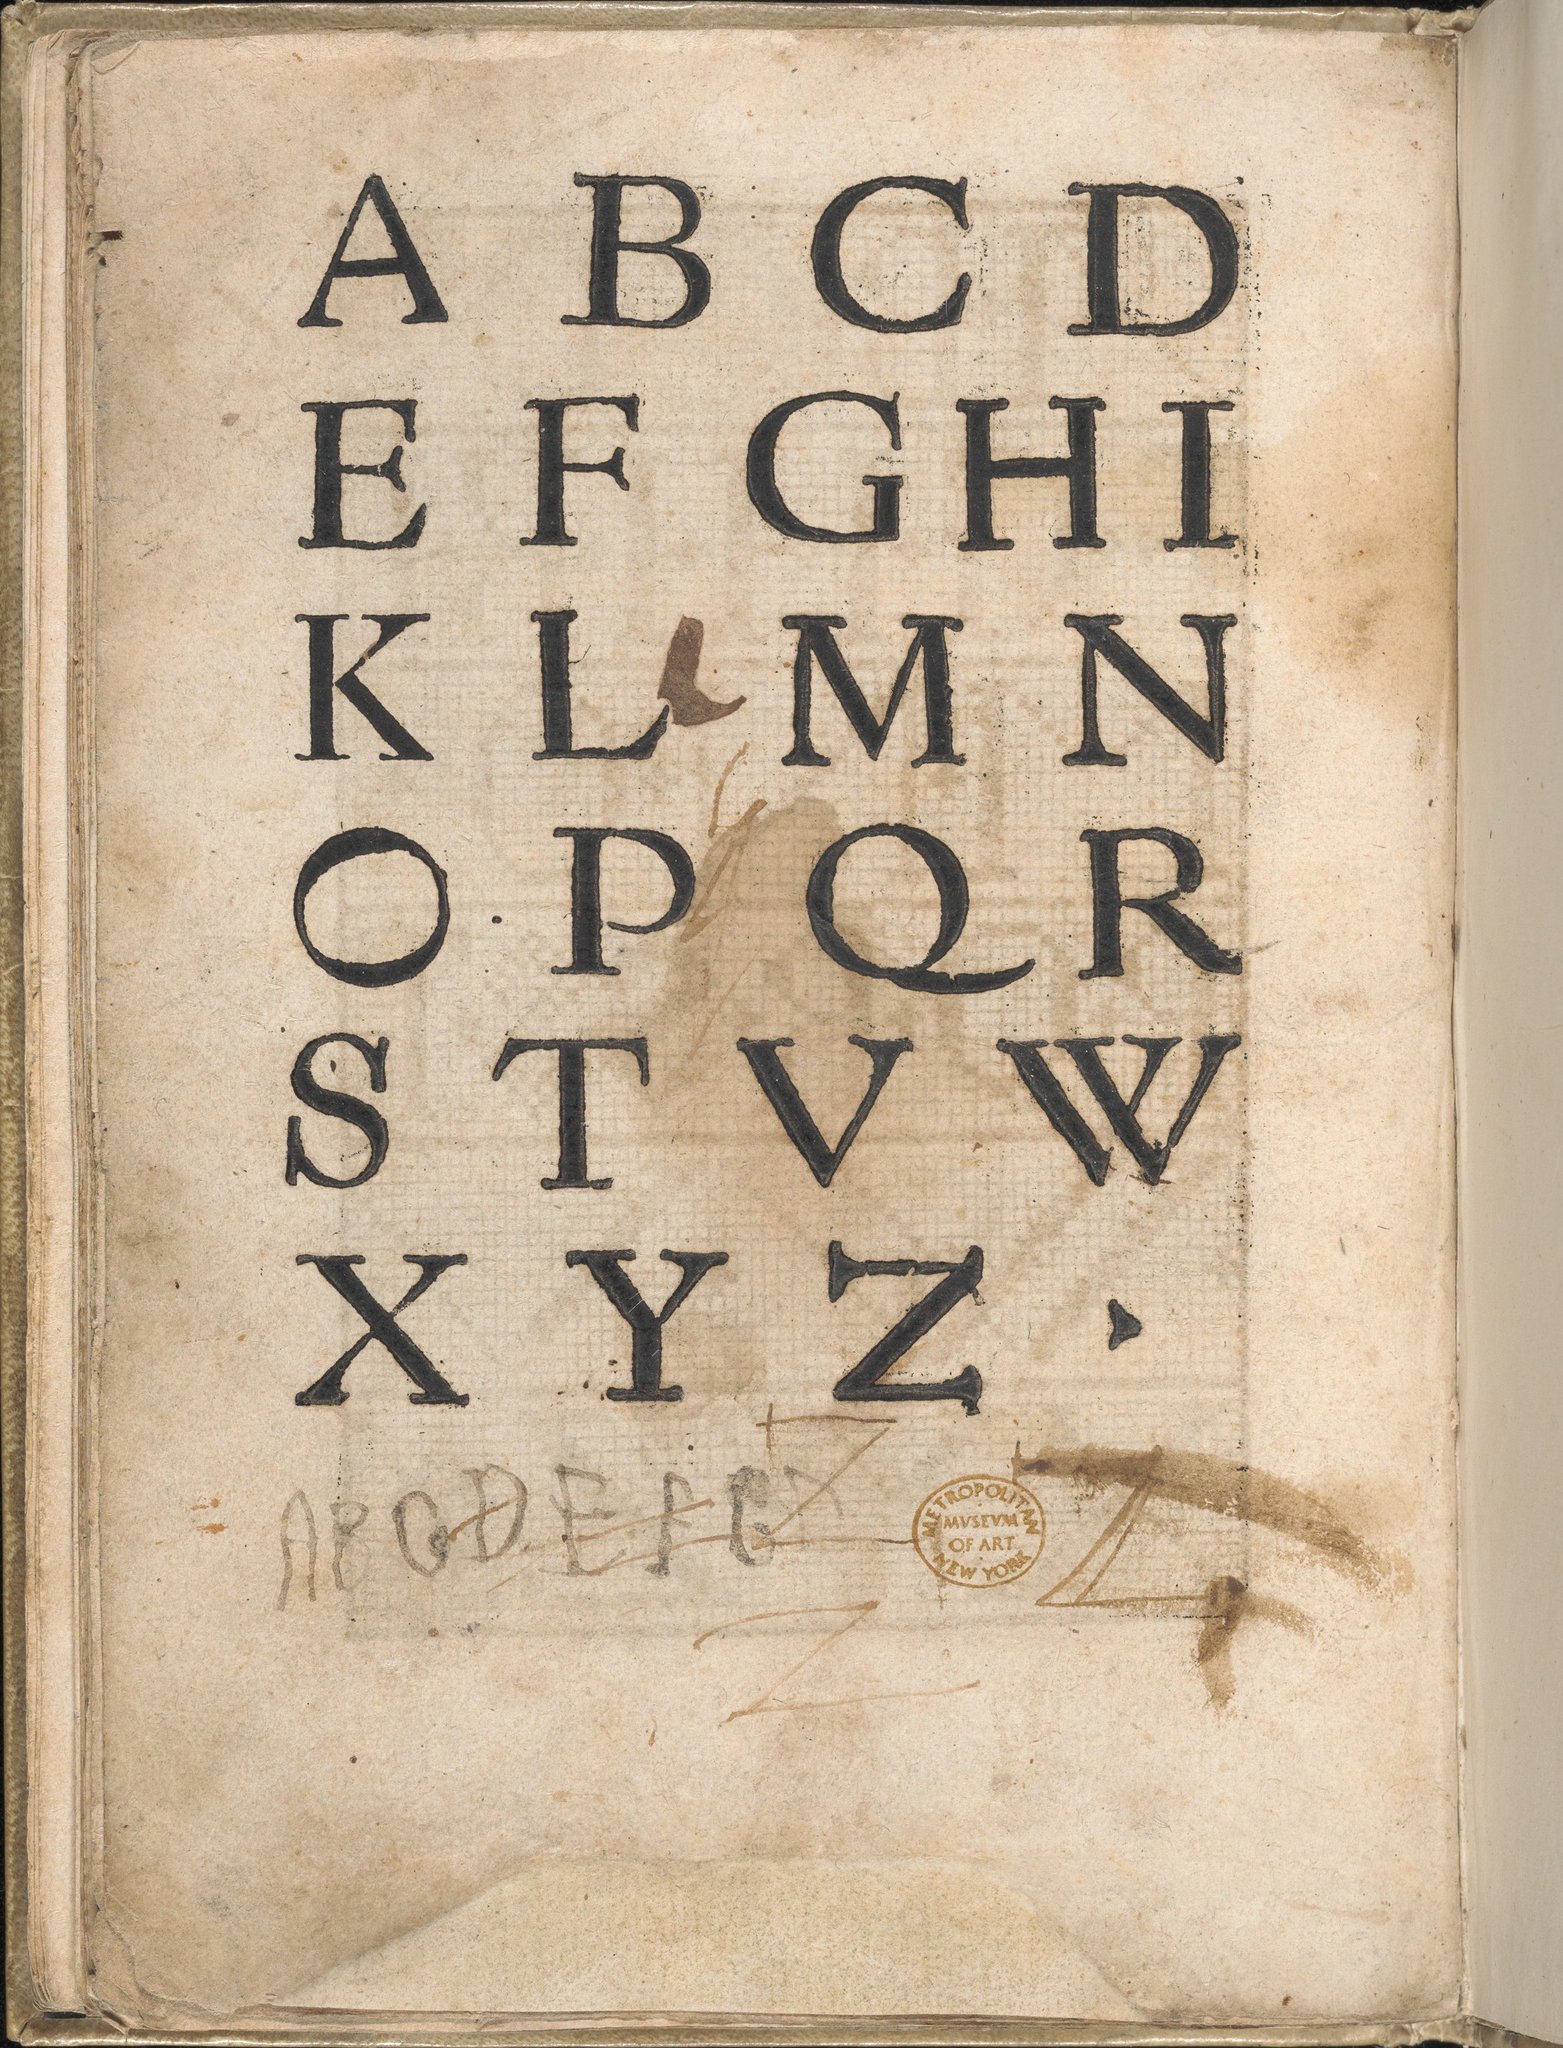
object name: book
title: Page 25v, from "Eyn New Kunstlichboich"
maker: peter quentel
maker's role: publisher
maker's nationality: german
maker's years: 1500-1550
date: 1529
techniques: woodcut